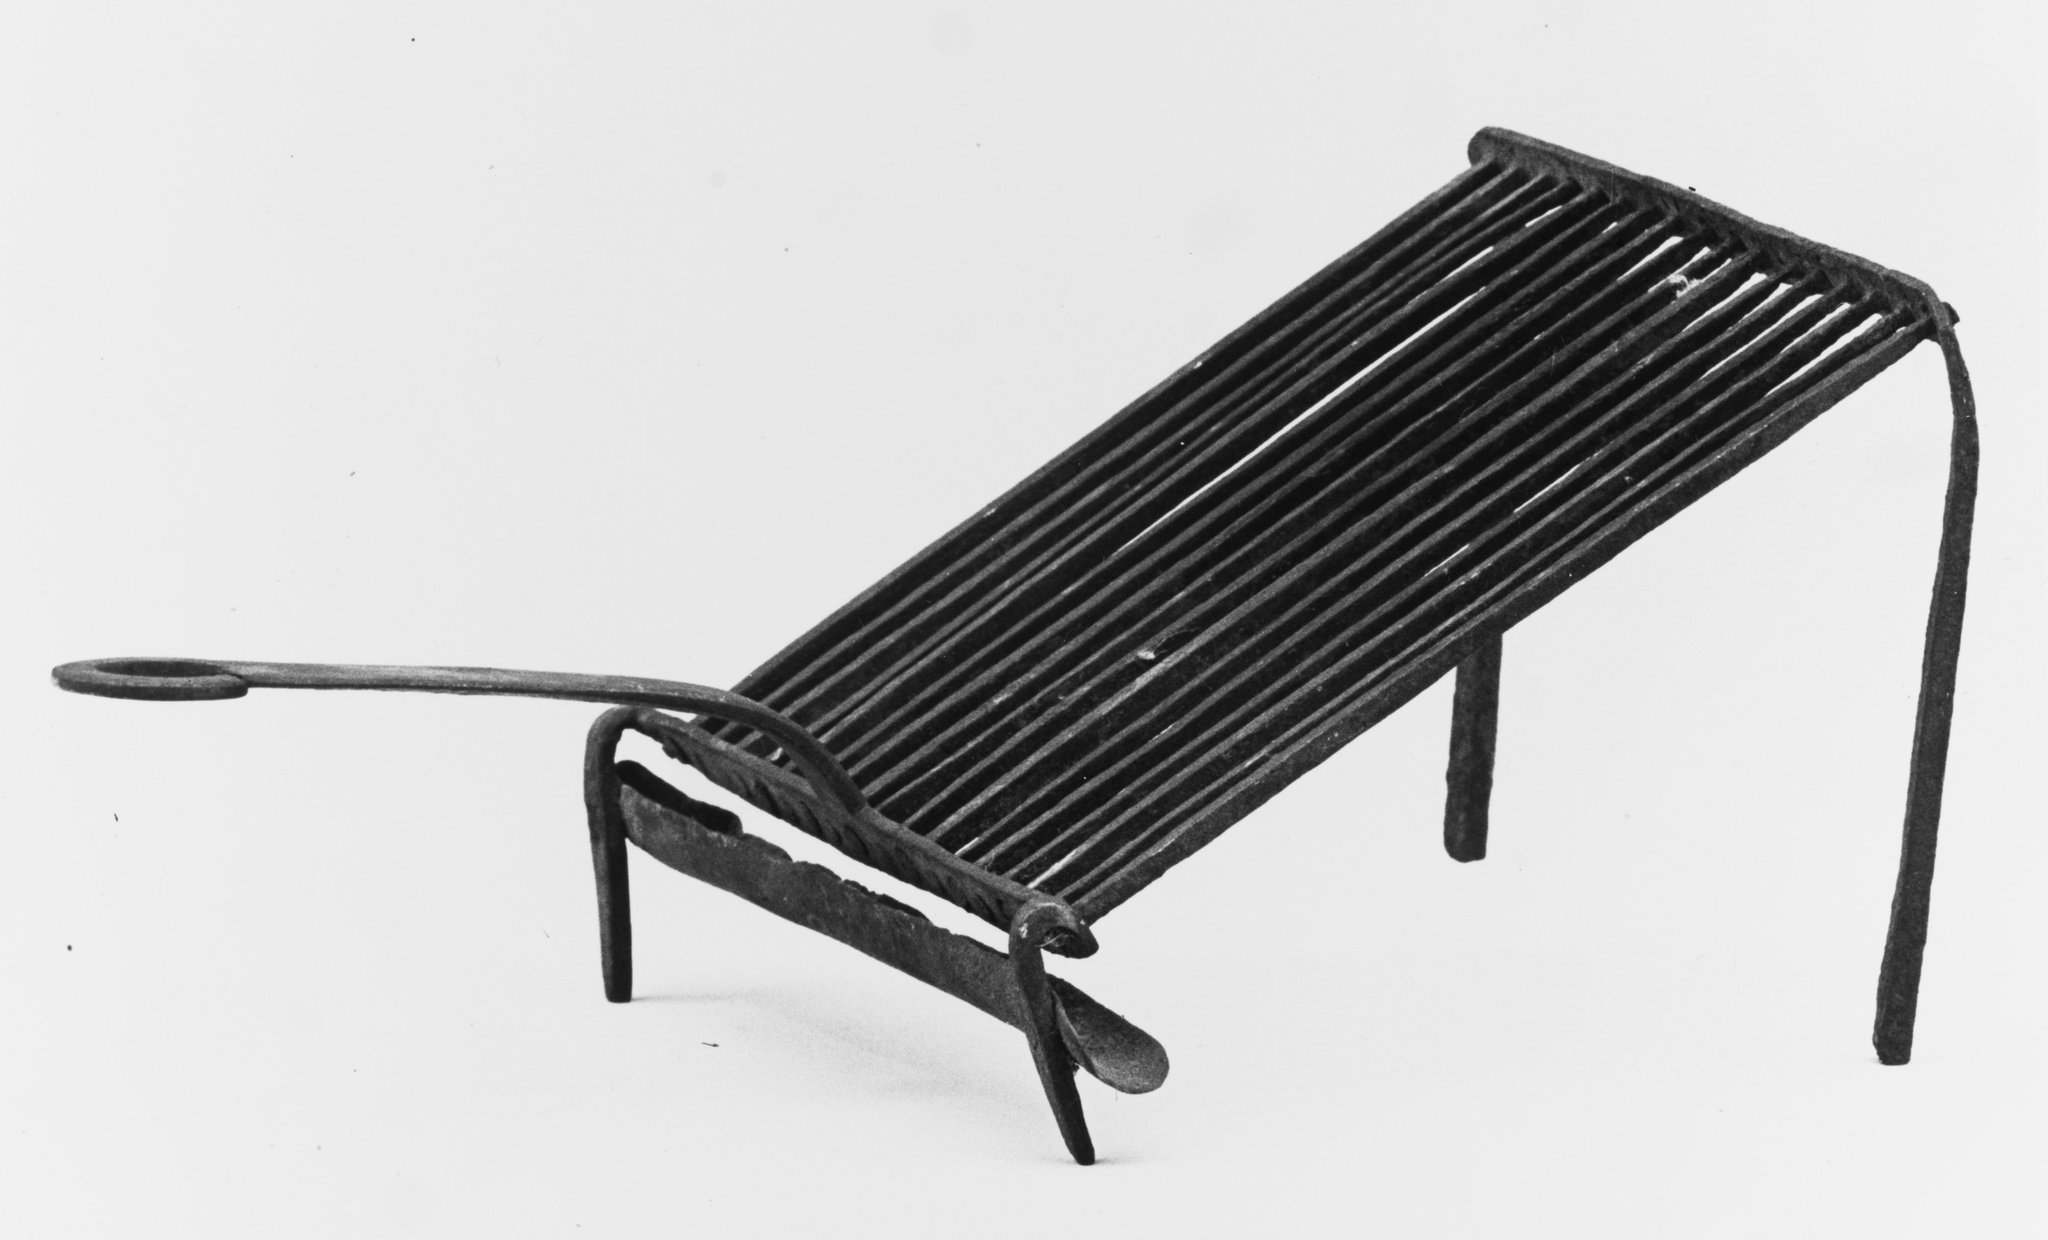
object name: gridiron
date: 1700-1900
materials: iron